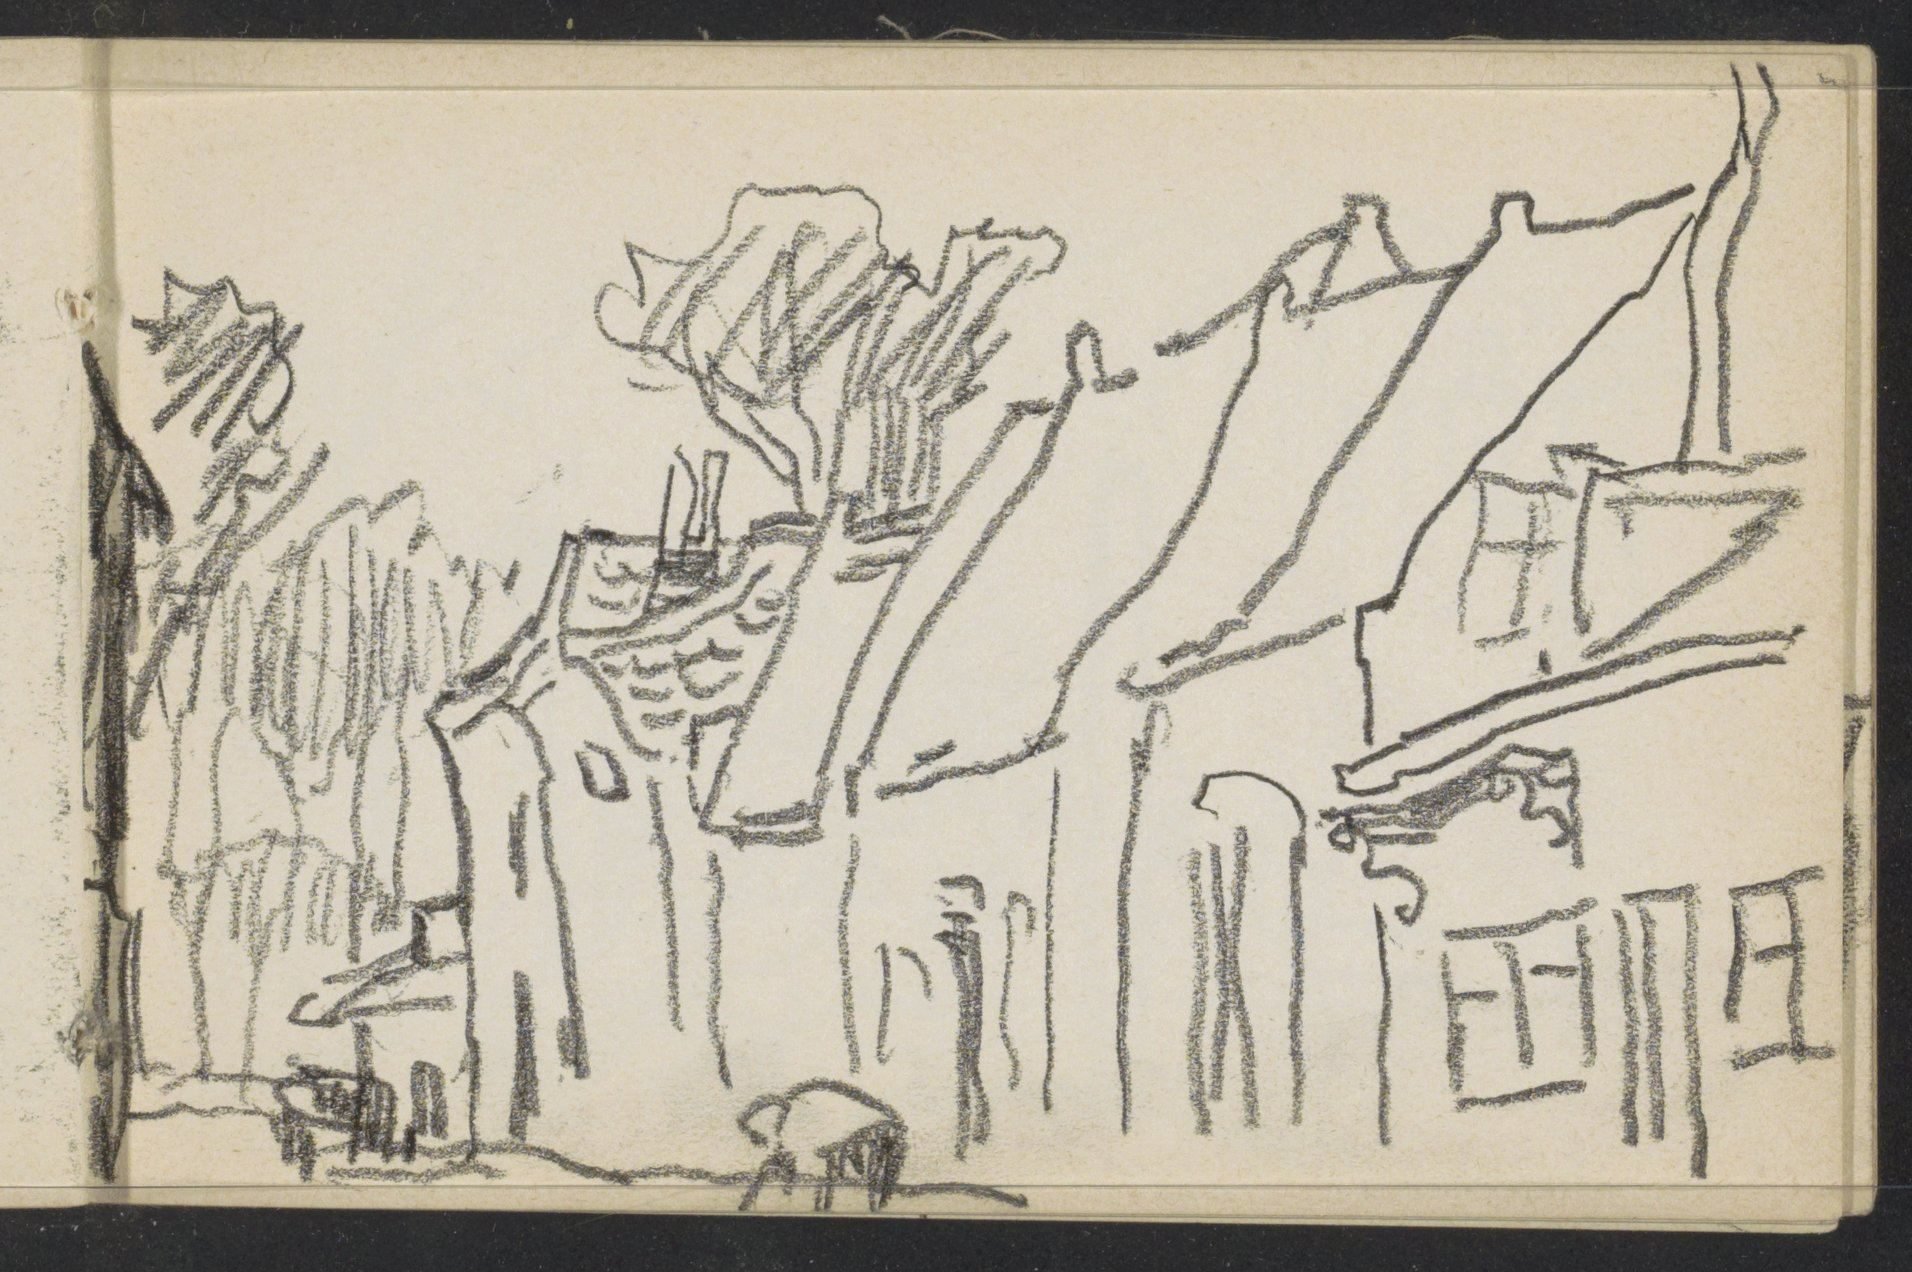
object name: sketchbook leaf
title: Dorpsstraat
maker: alexander shilling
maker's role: draughtsman, print maker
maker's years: 1859-1937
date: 1910-1923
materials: chalk, paper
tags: village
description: Blad 12 recto uit een schetsboek met 26 bladen.